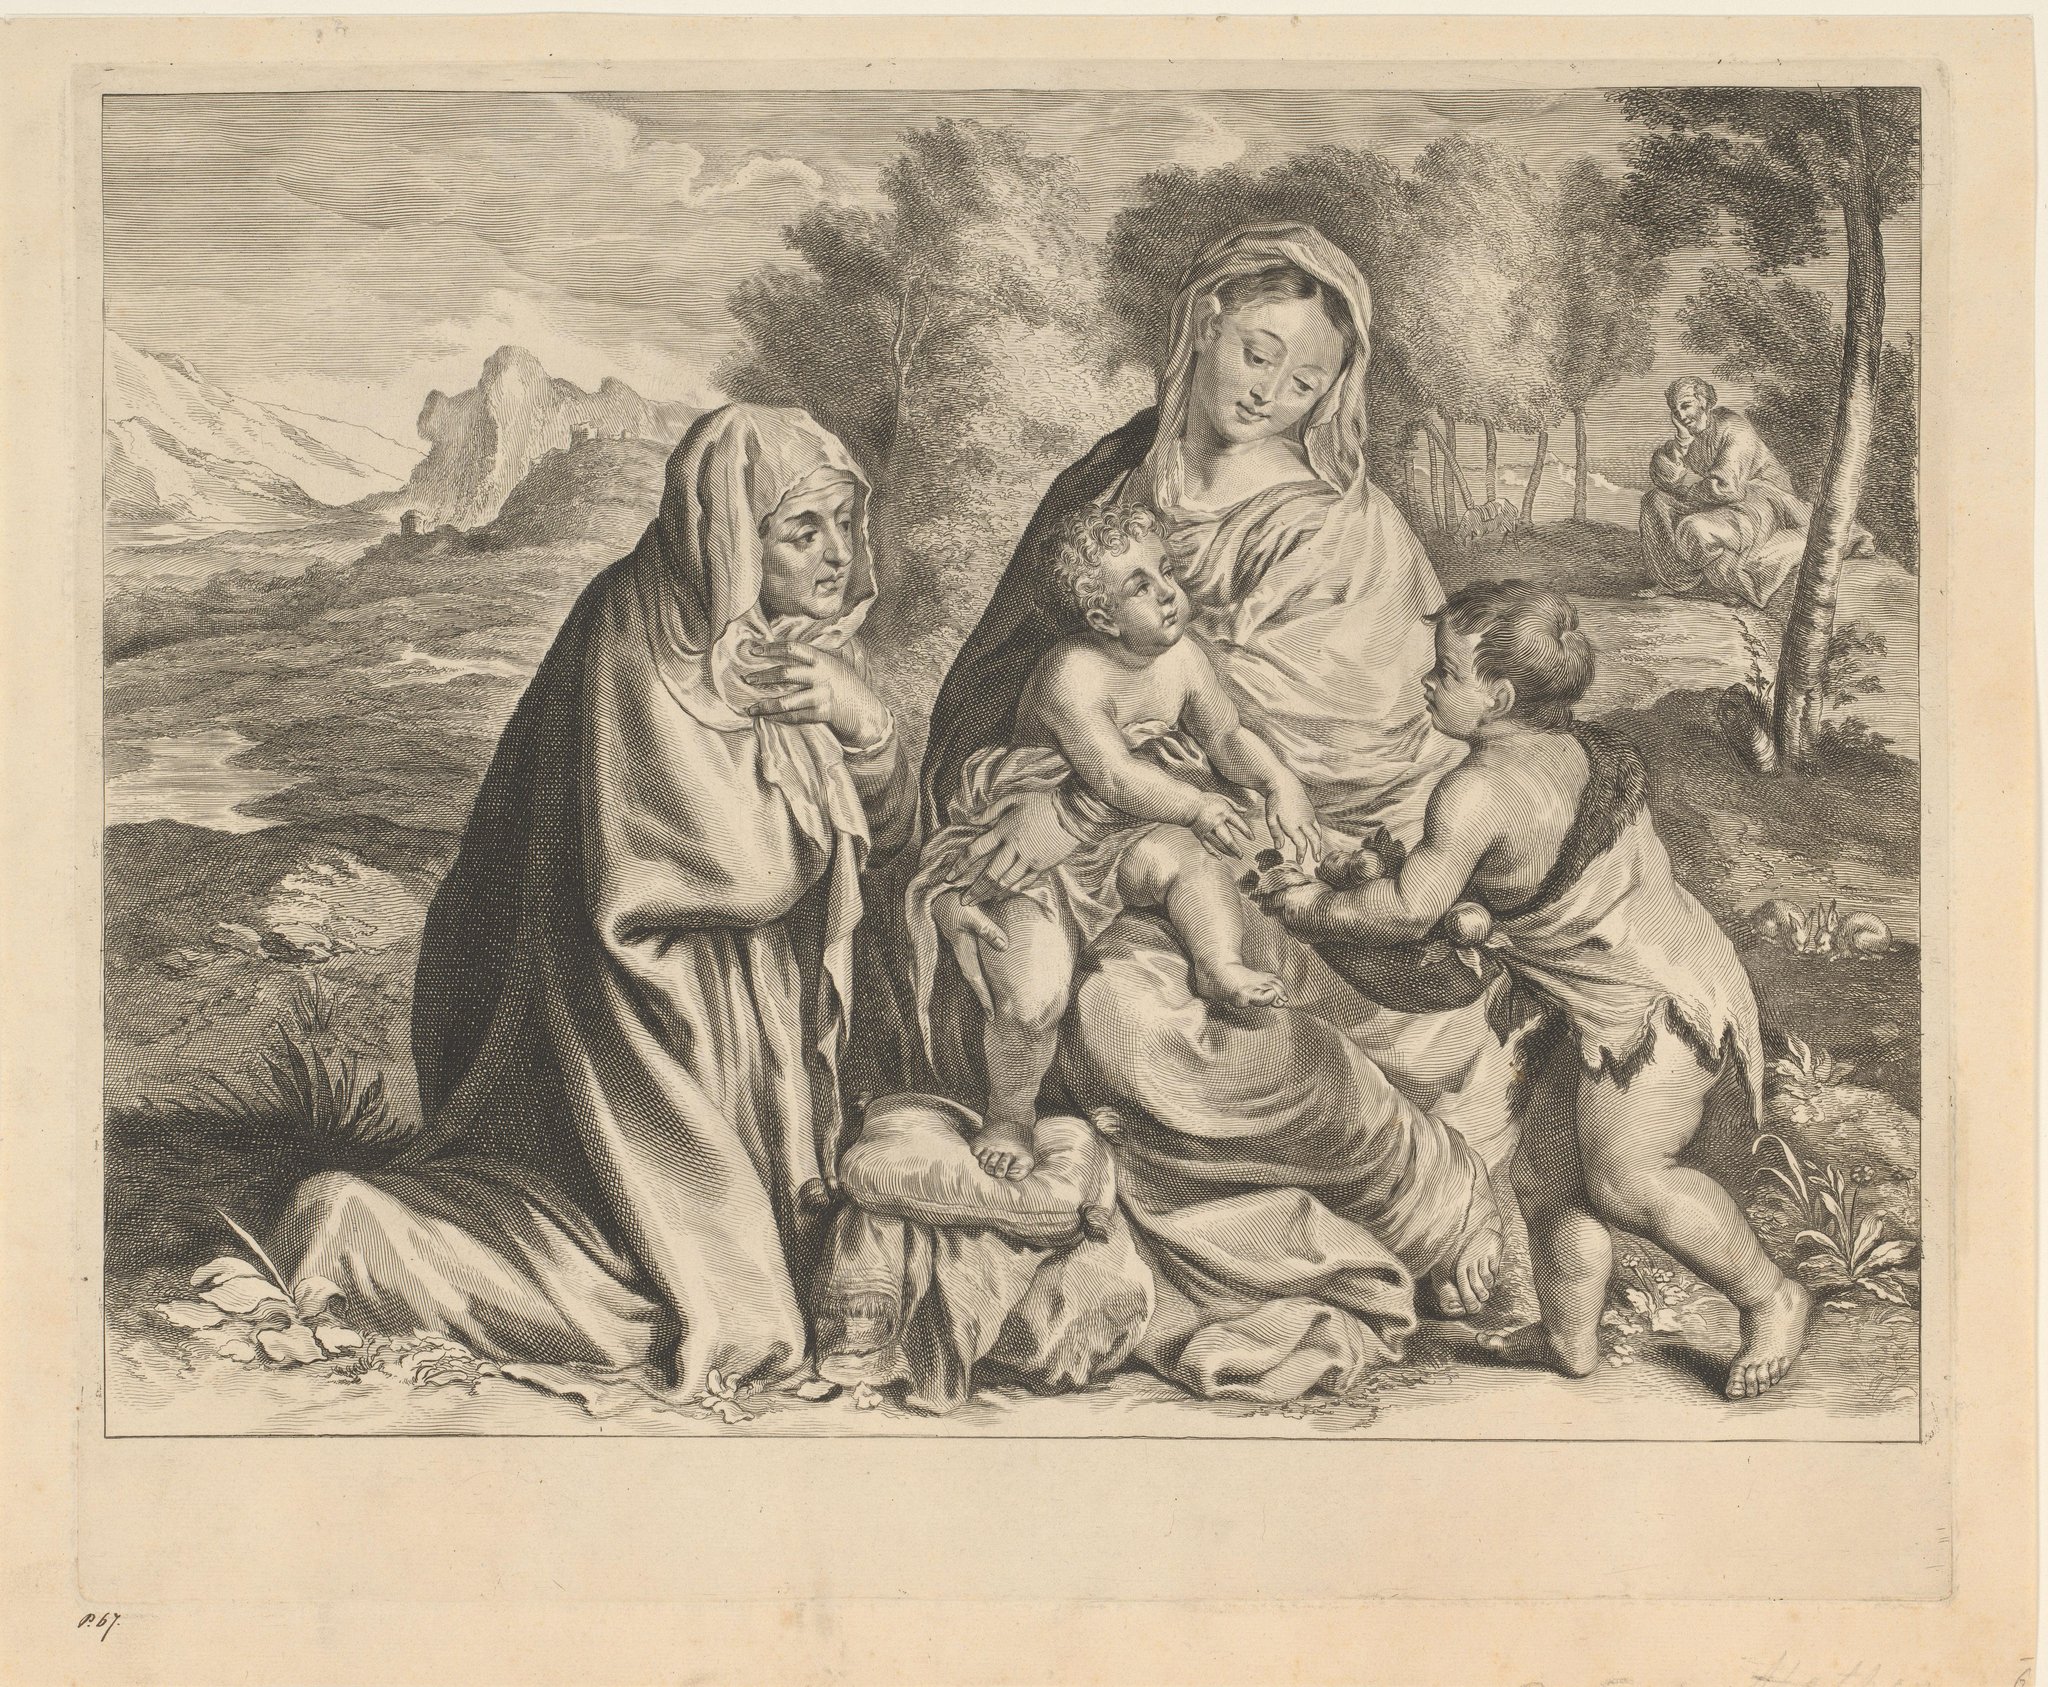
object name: print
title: Landschap met de Heilige Familie, Johannes de Doper en Elisabet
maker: titiaan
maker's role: draughtsman, painter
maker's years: 1488-1576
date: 1646-1658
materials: paper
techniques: engraving, etching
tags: holy family with john the baptist (as child), fruits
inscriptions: collector's mark: Lugt 11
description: Deze prent maakte ten minste tot 1979 deel uit van een prentalbum met de titel: 't Cabinet der Italiaense schilderije antique statue en borstbeelde van de heer Renst 145 stucks. Simon Schijnvoet heeft in 1709 aan dit album het Schijnvoet-nummer 22, liber nummer 20 toegekend. Prent uit serie Caelaturae met vierendertig reprodukties naar Italiaanse en Nederlandse schilders, vervaardigd door de allerbeste graveurs in opdracht van de verzamelaar Gerard Reynst.